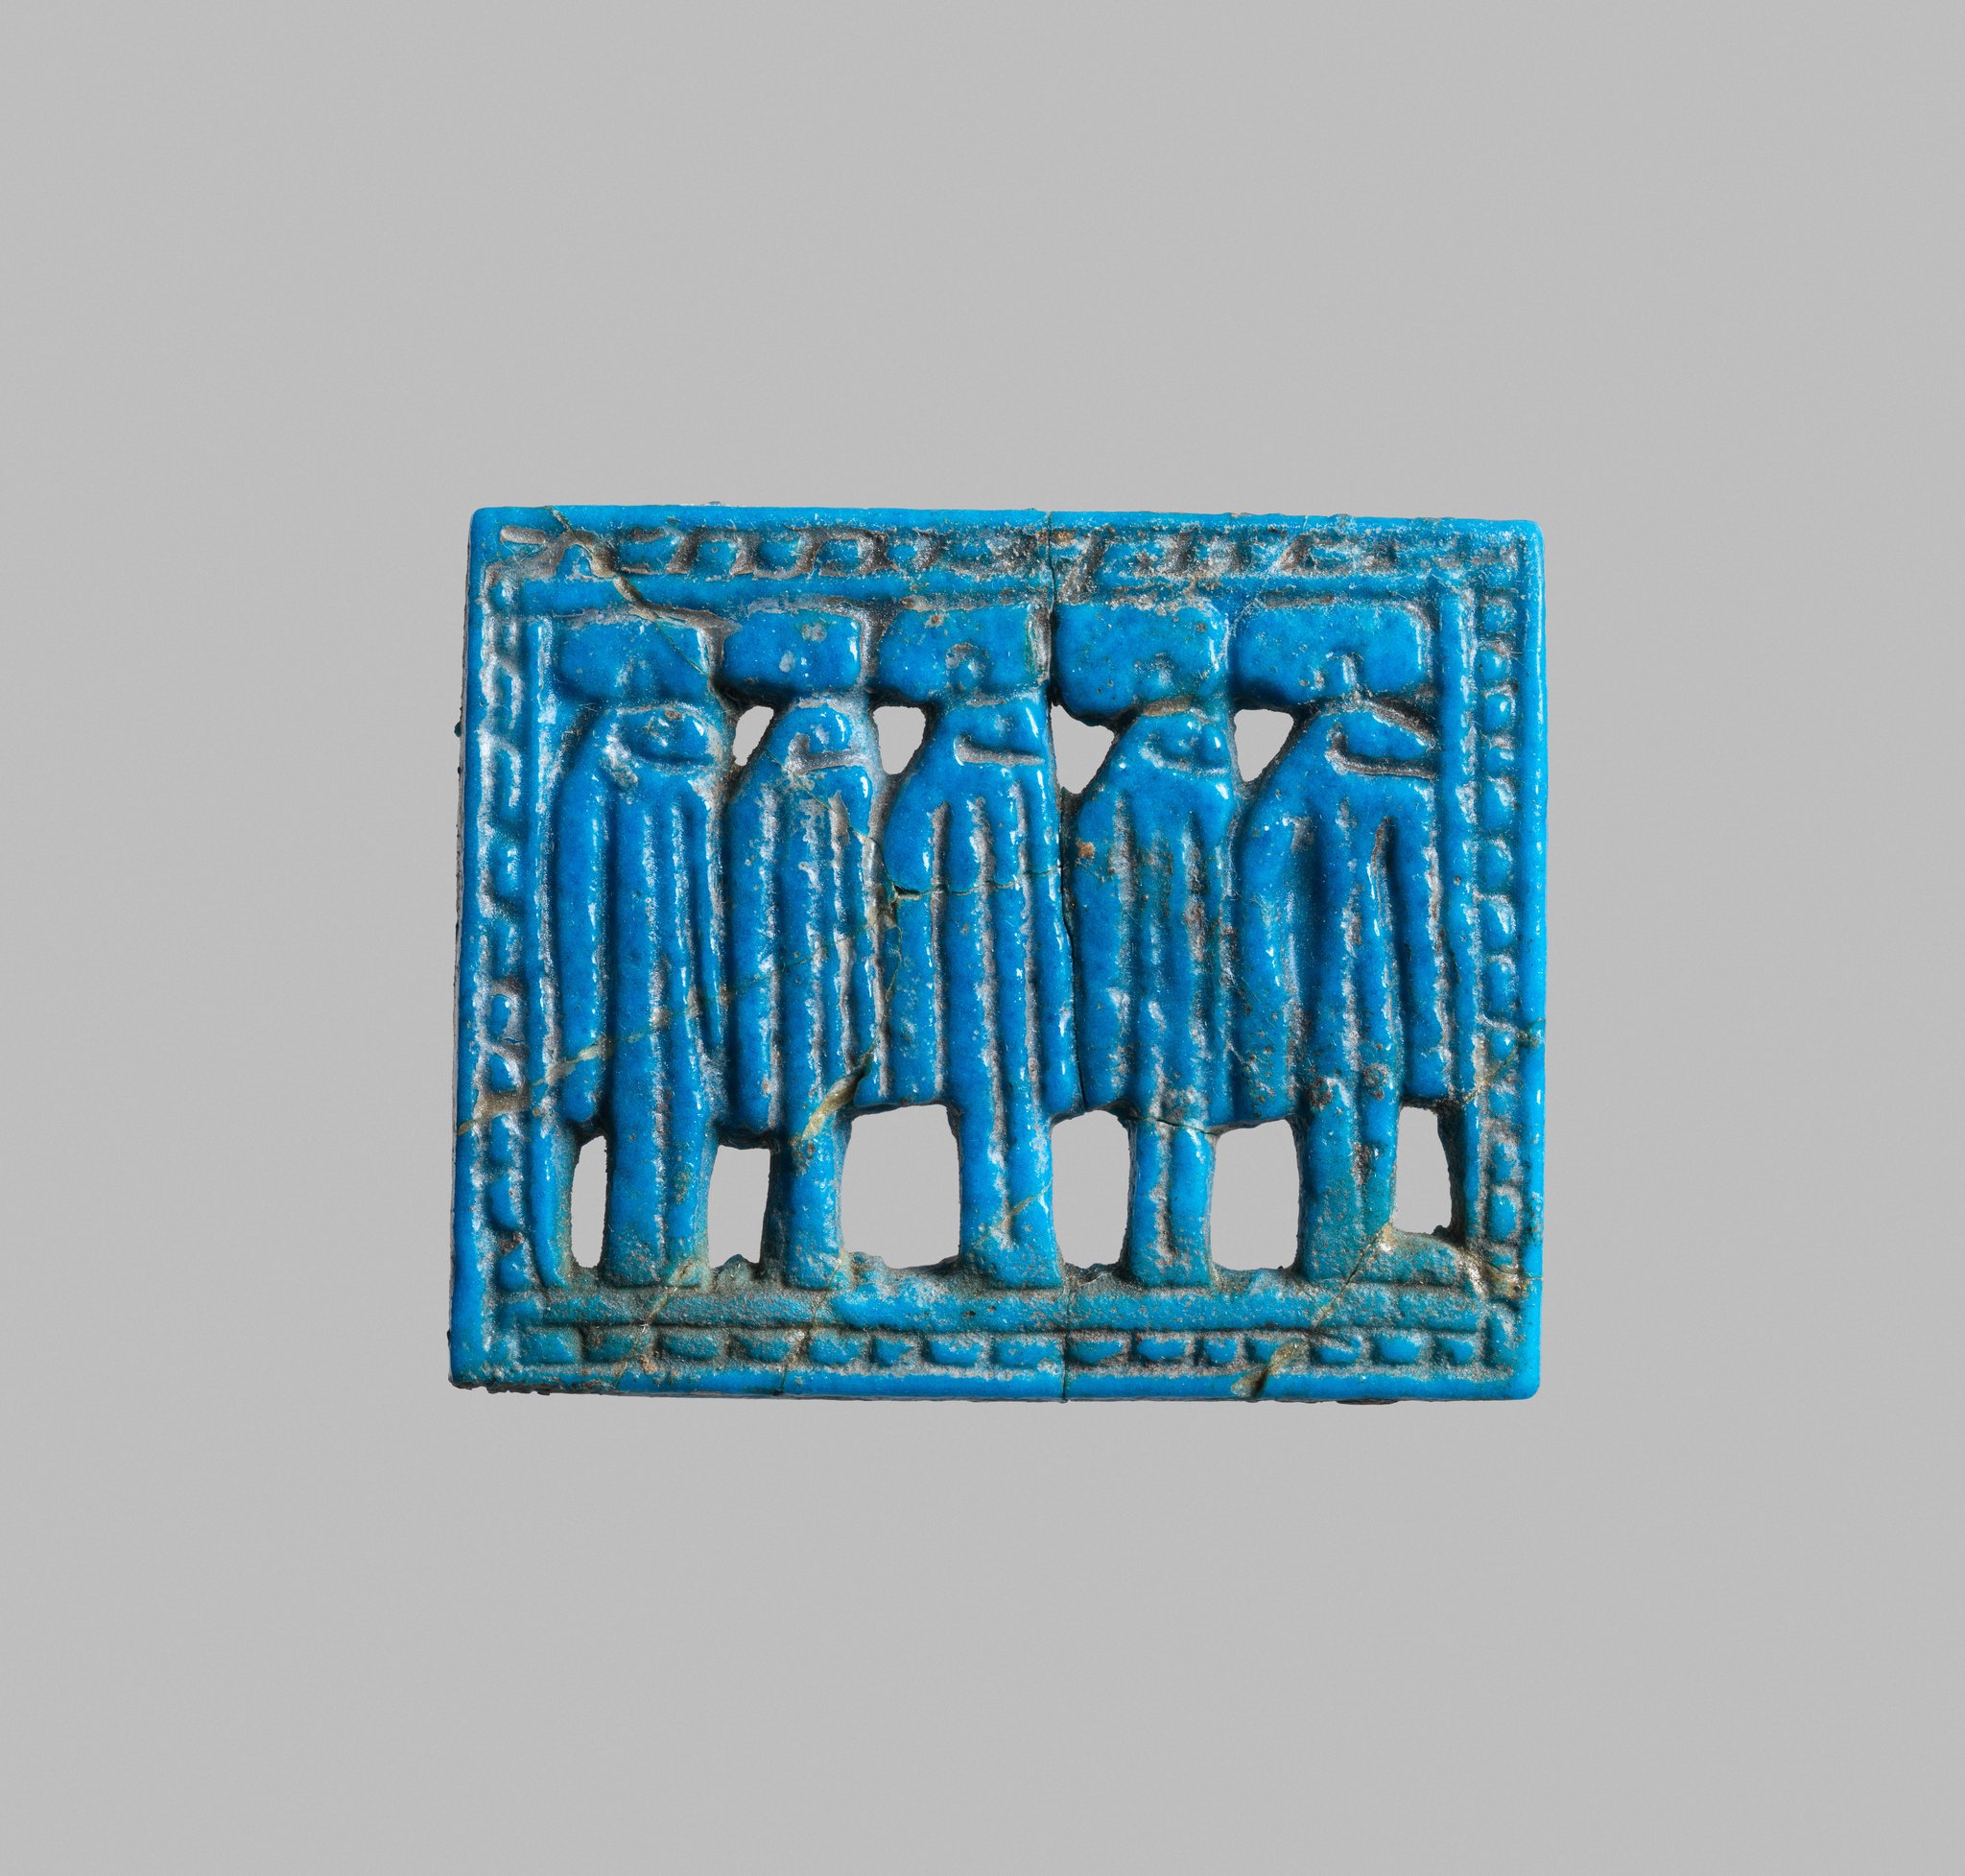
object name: amulet plaque, openwork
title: Openwork Amulet Plaque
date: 1070-525 BCE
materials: faience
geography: egypt